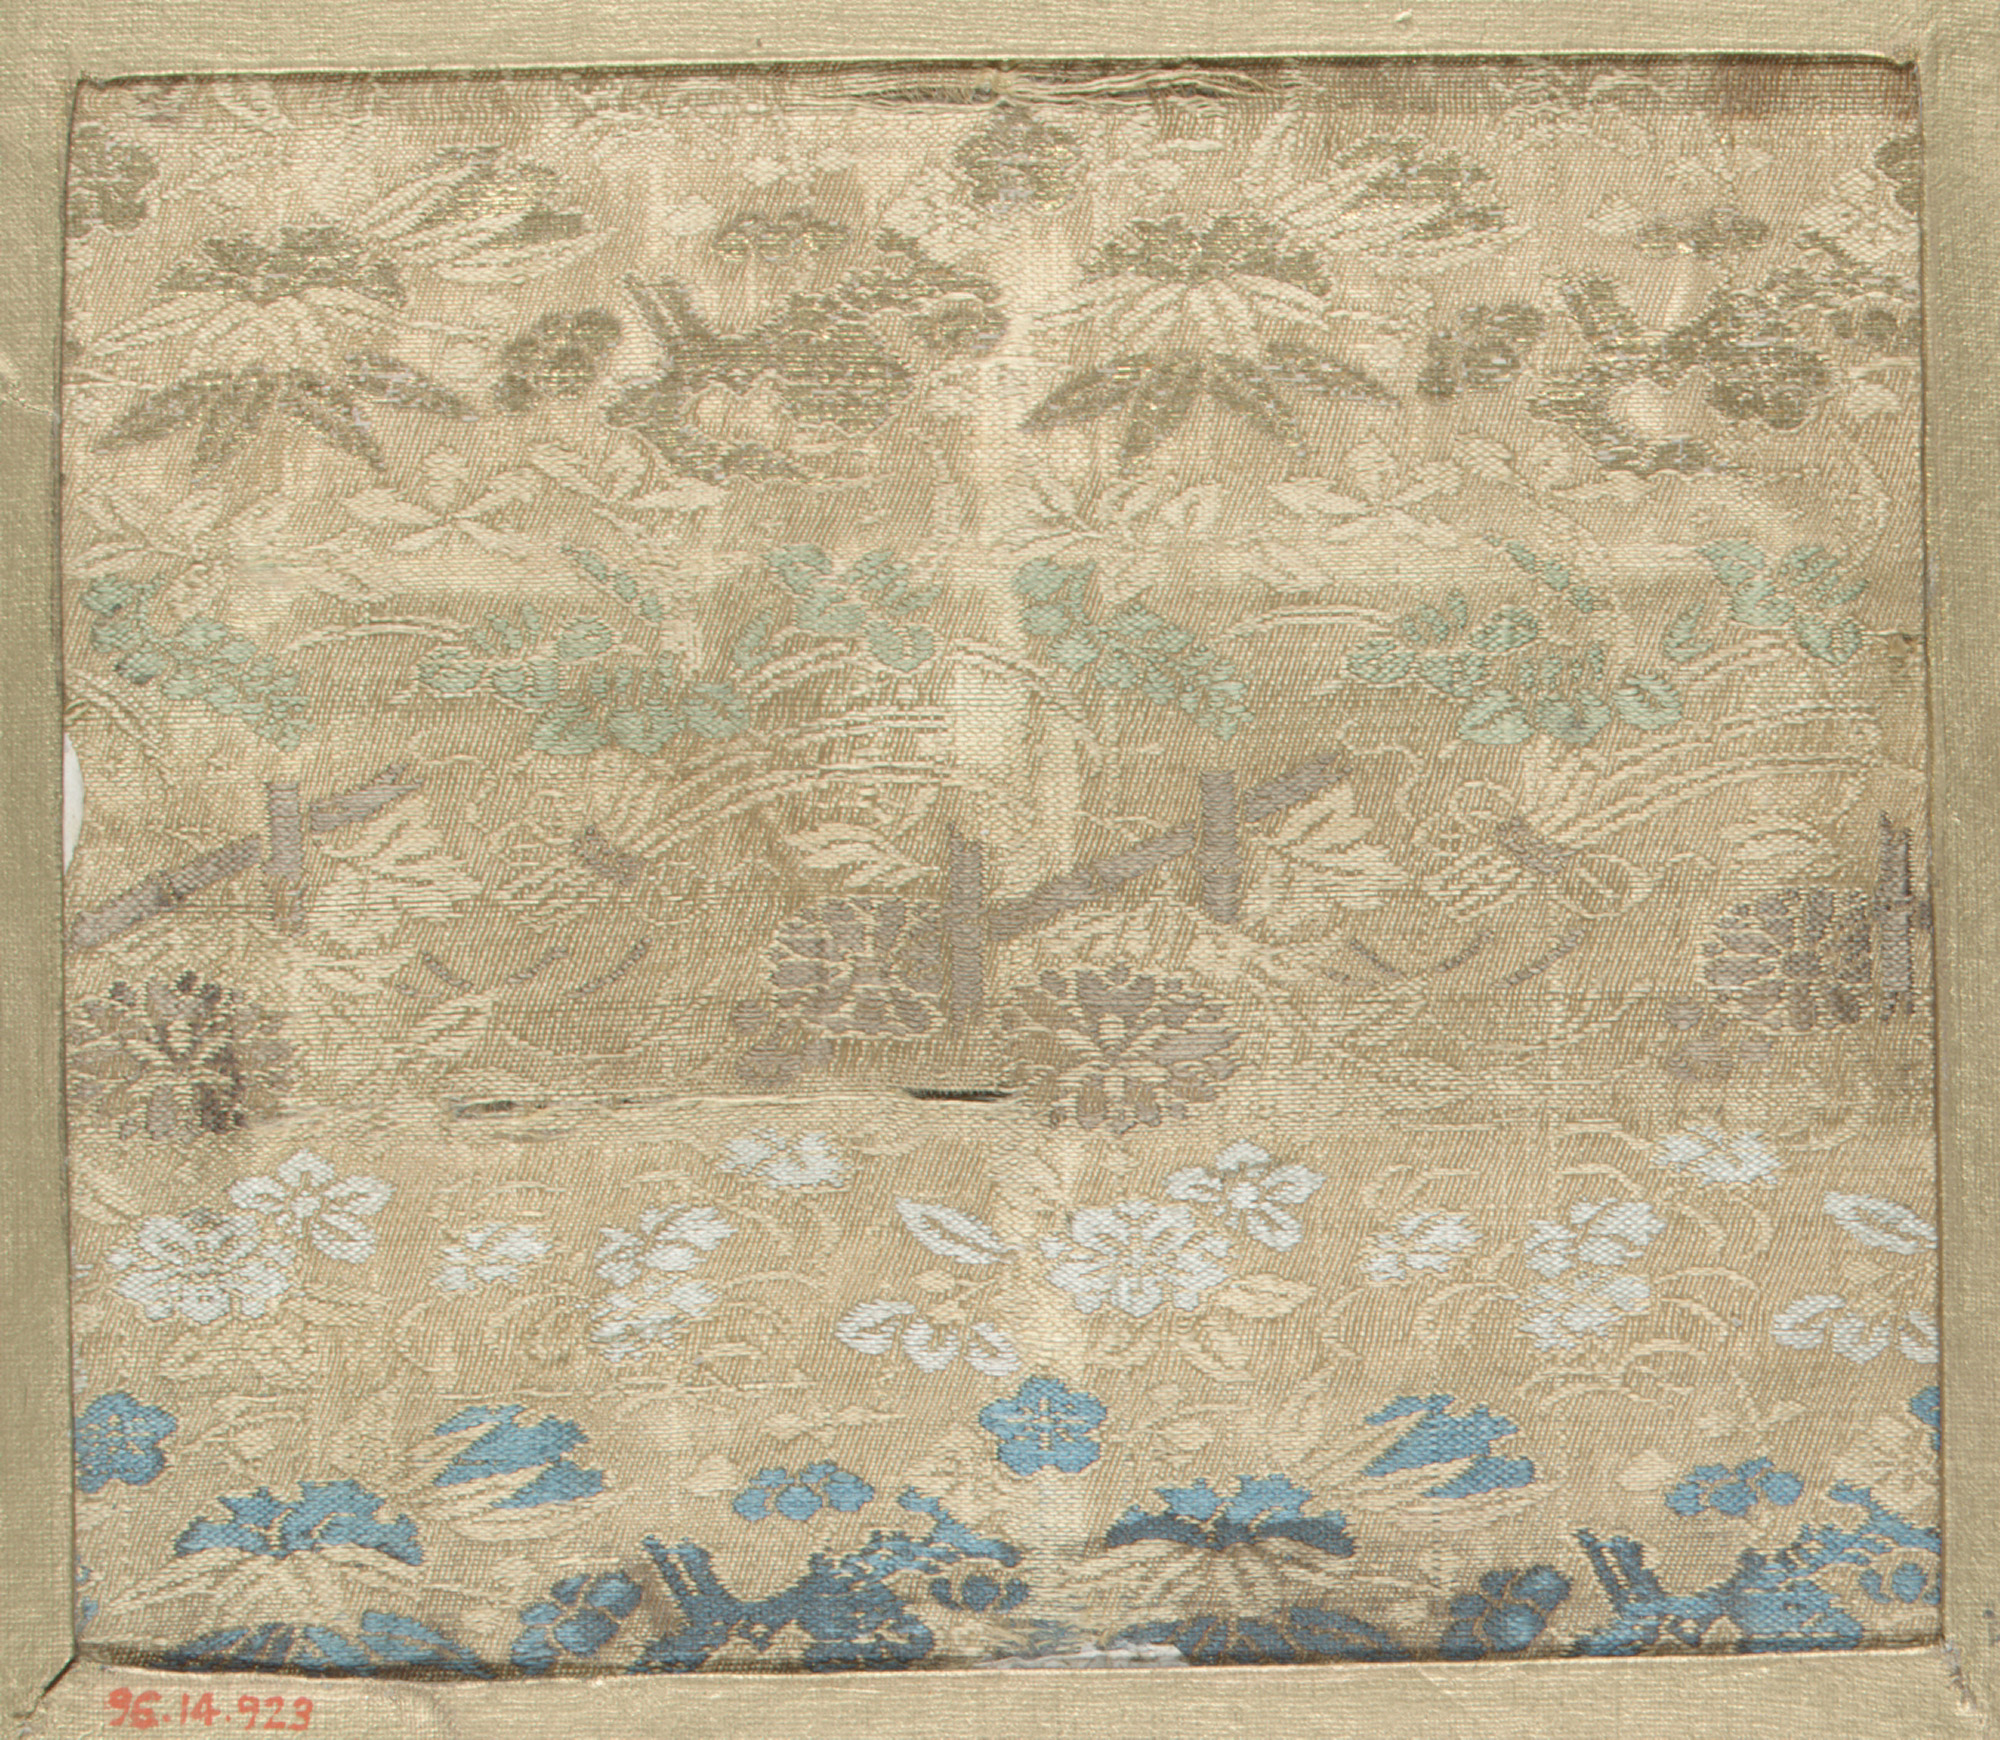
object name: piece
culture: japanese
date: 1701-1900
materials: silk